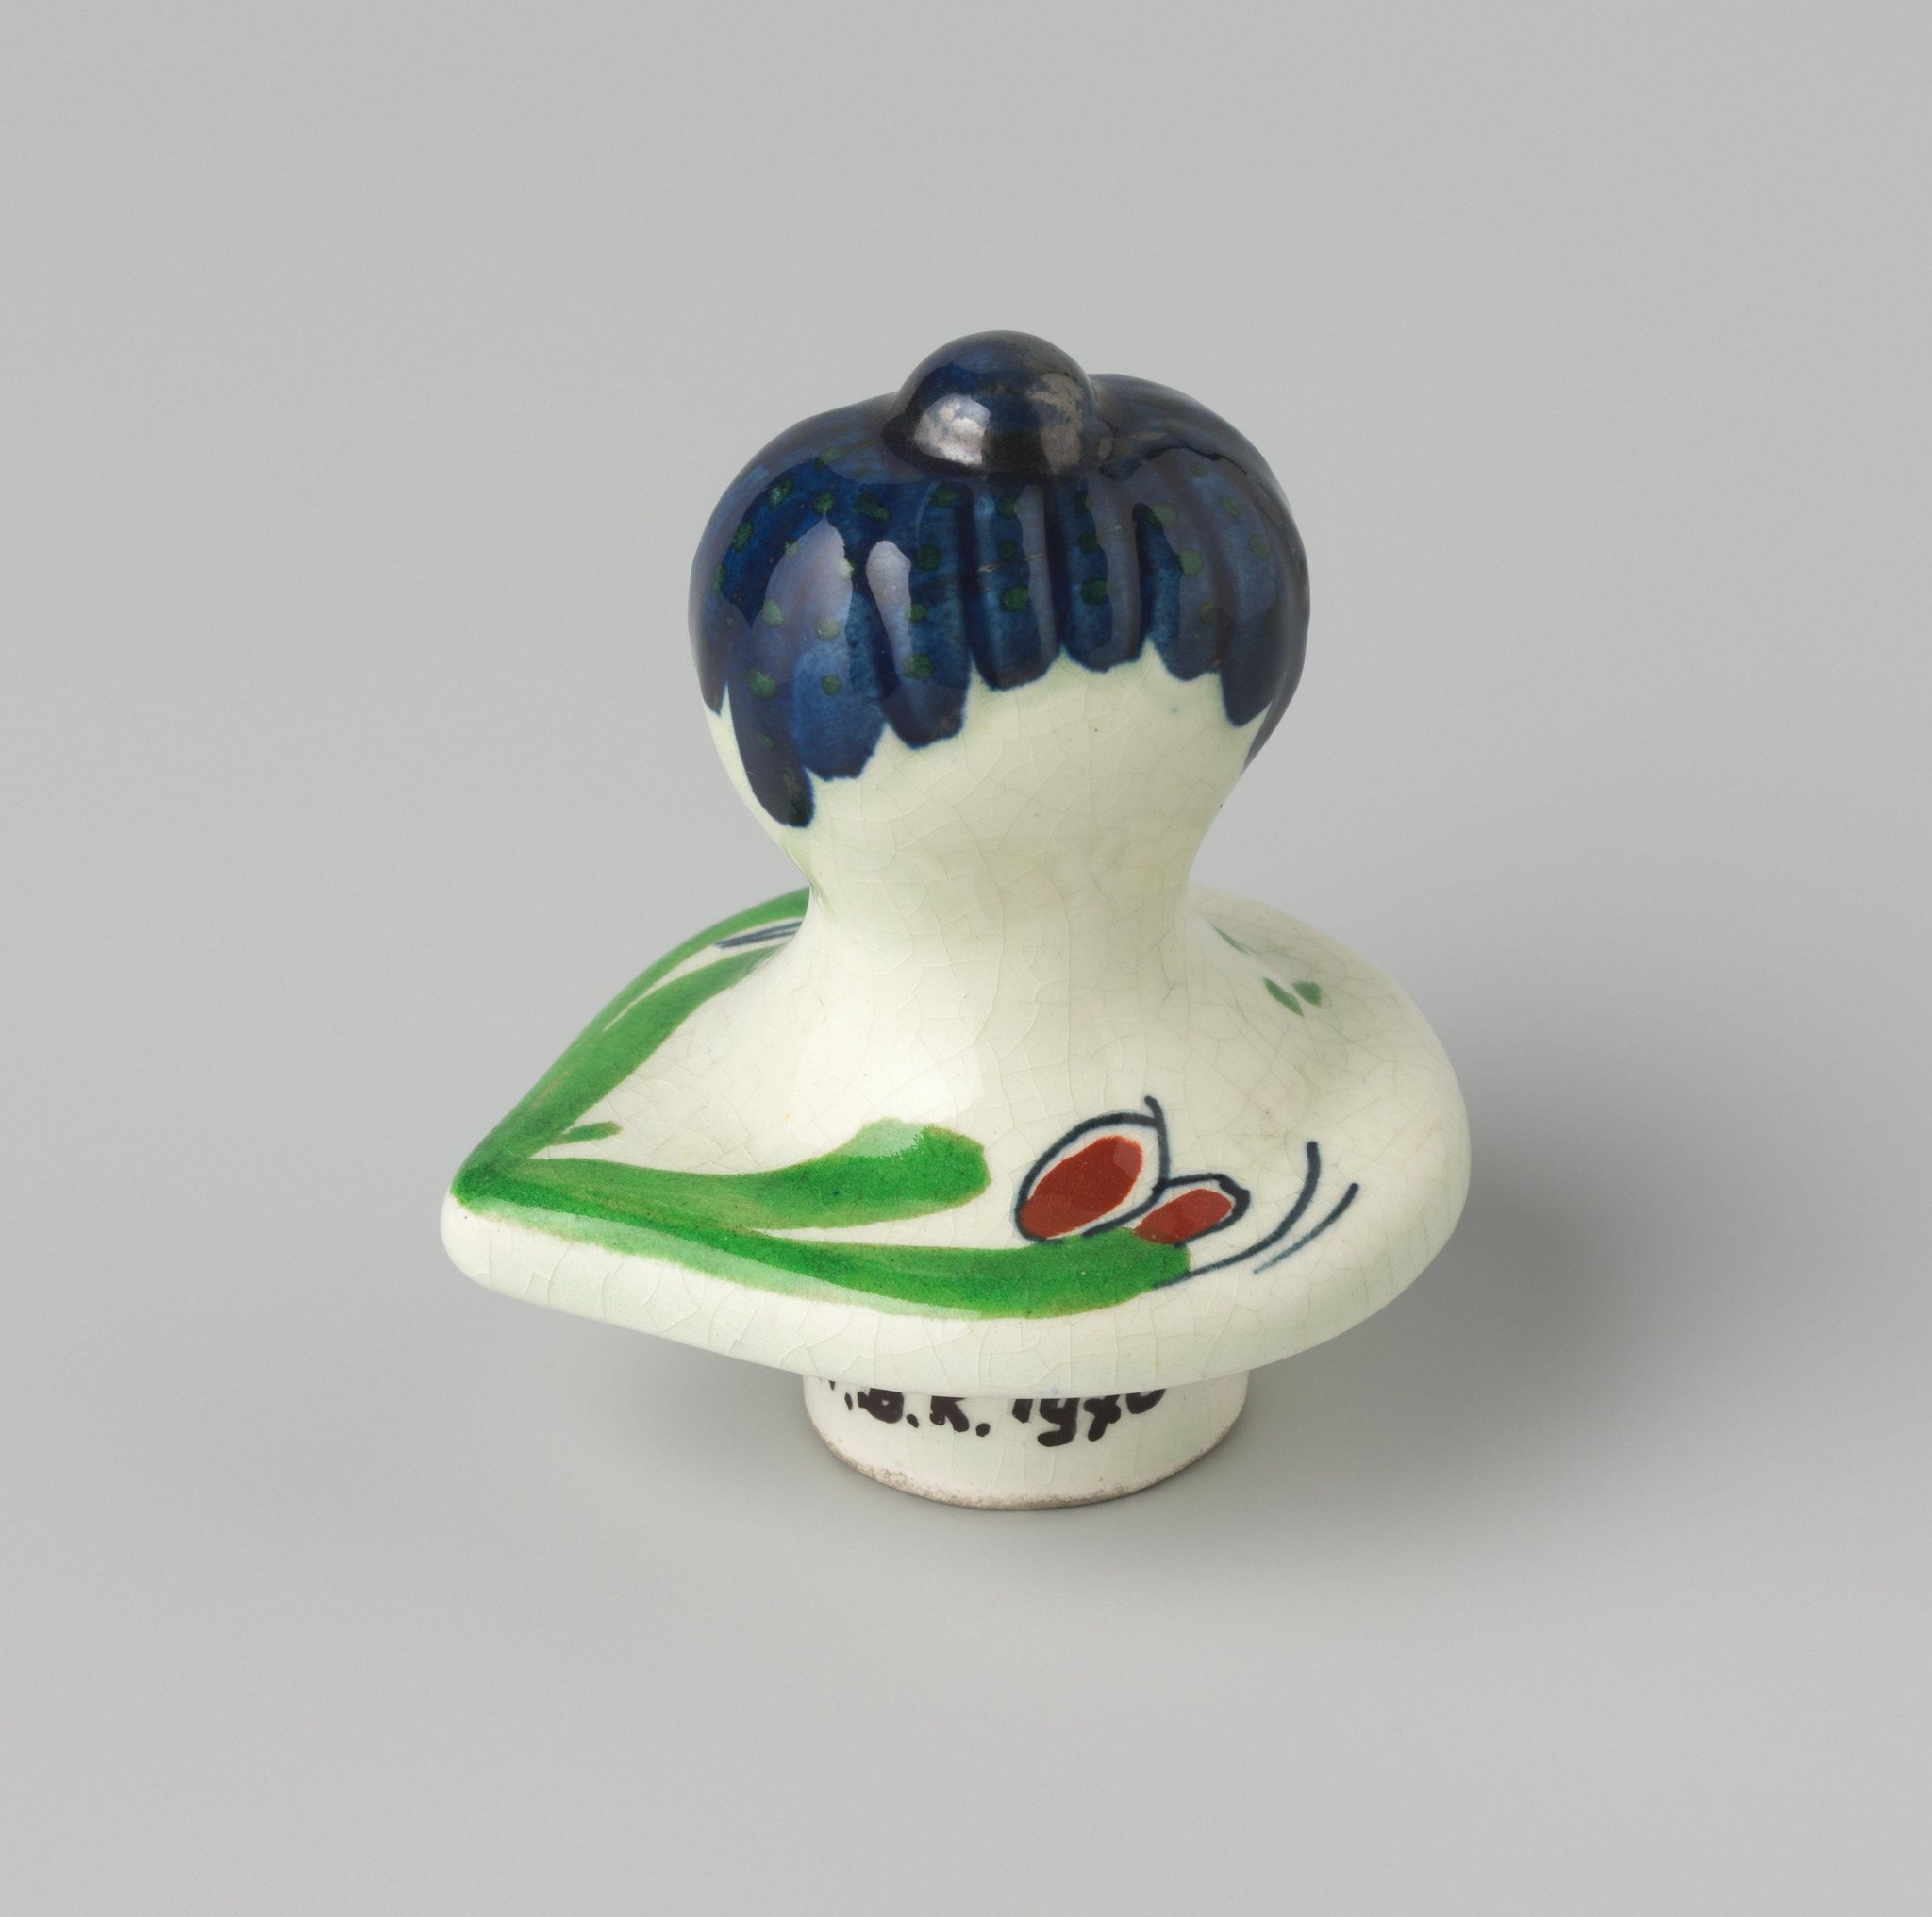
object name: vessel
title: Deksel van een kan, beschilderd met bladmotieven en vogels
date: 1900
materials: earthenware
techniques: painted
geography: delft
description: Deksel van een kan (A) van aardewerk, beschilderd met bladmotieven en vogels in blauw, rood en groen. Gemerkt (kan).